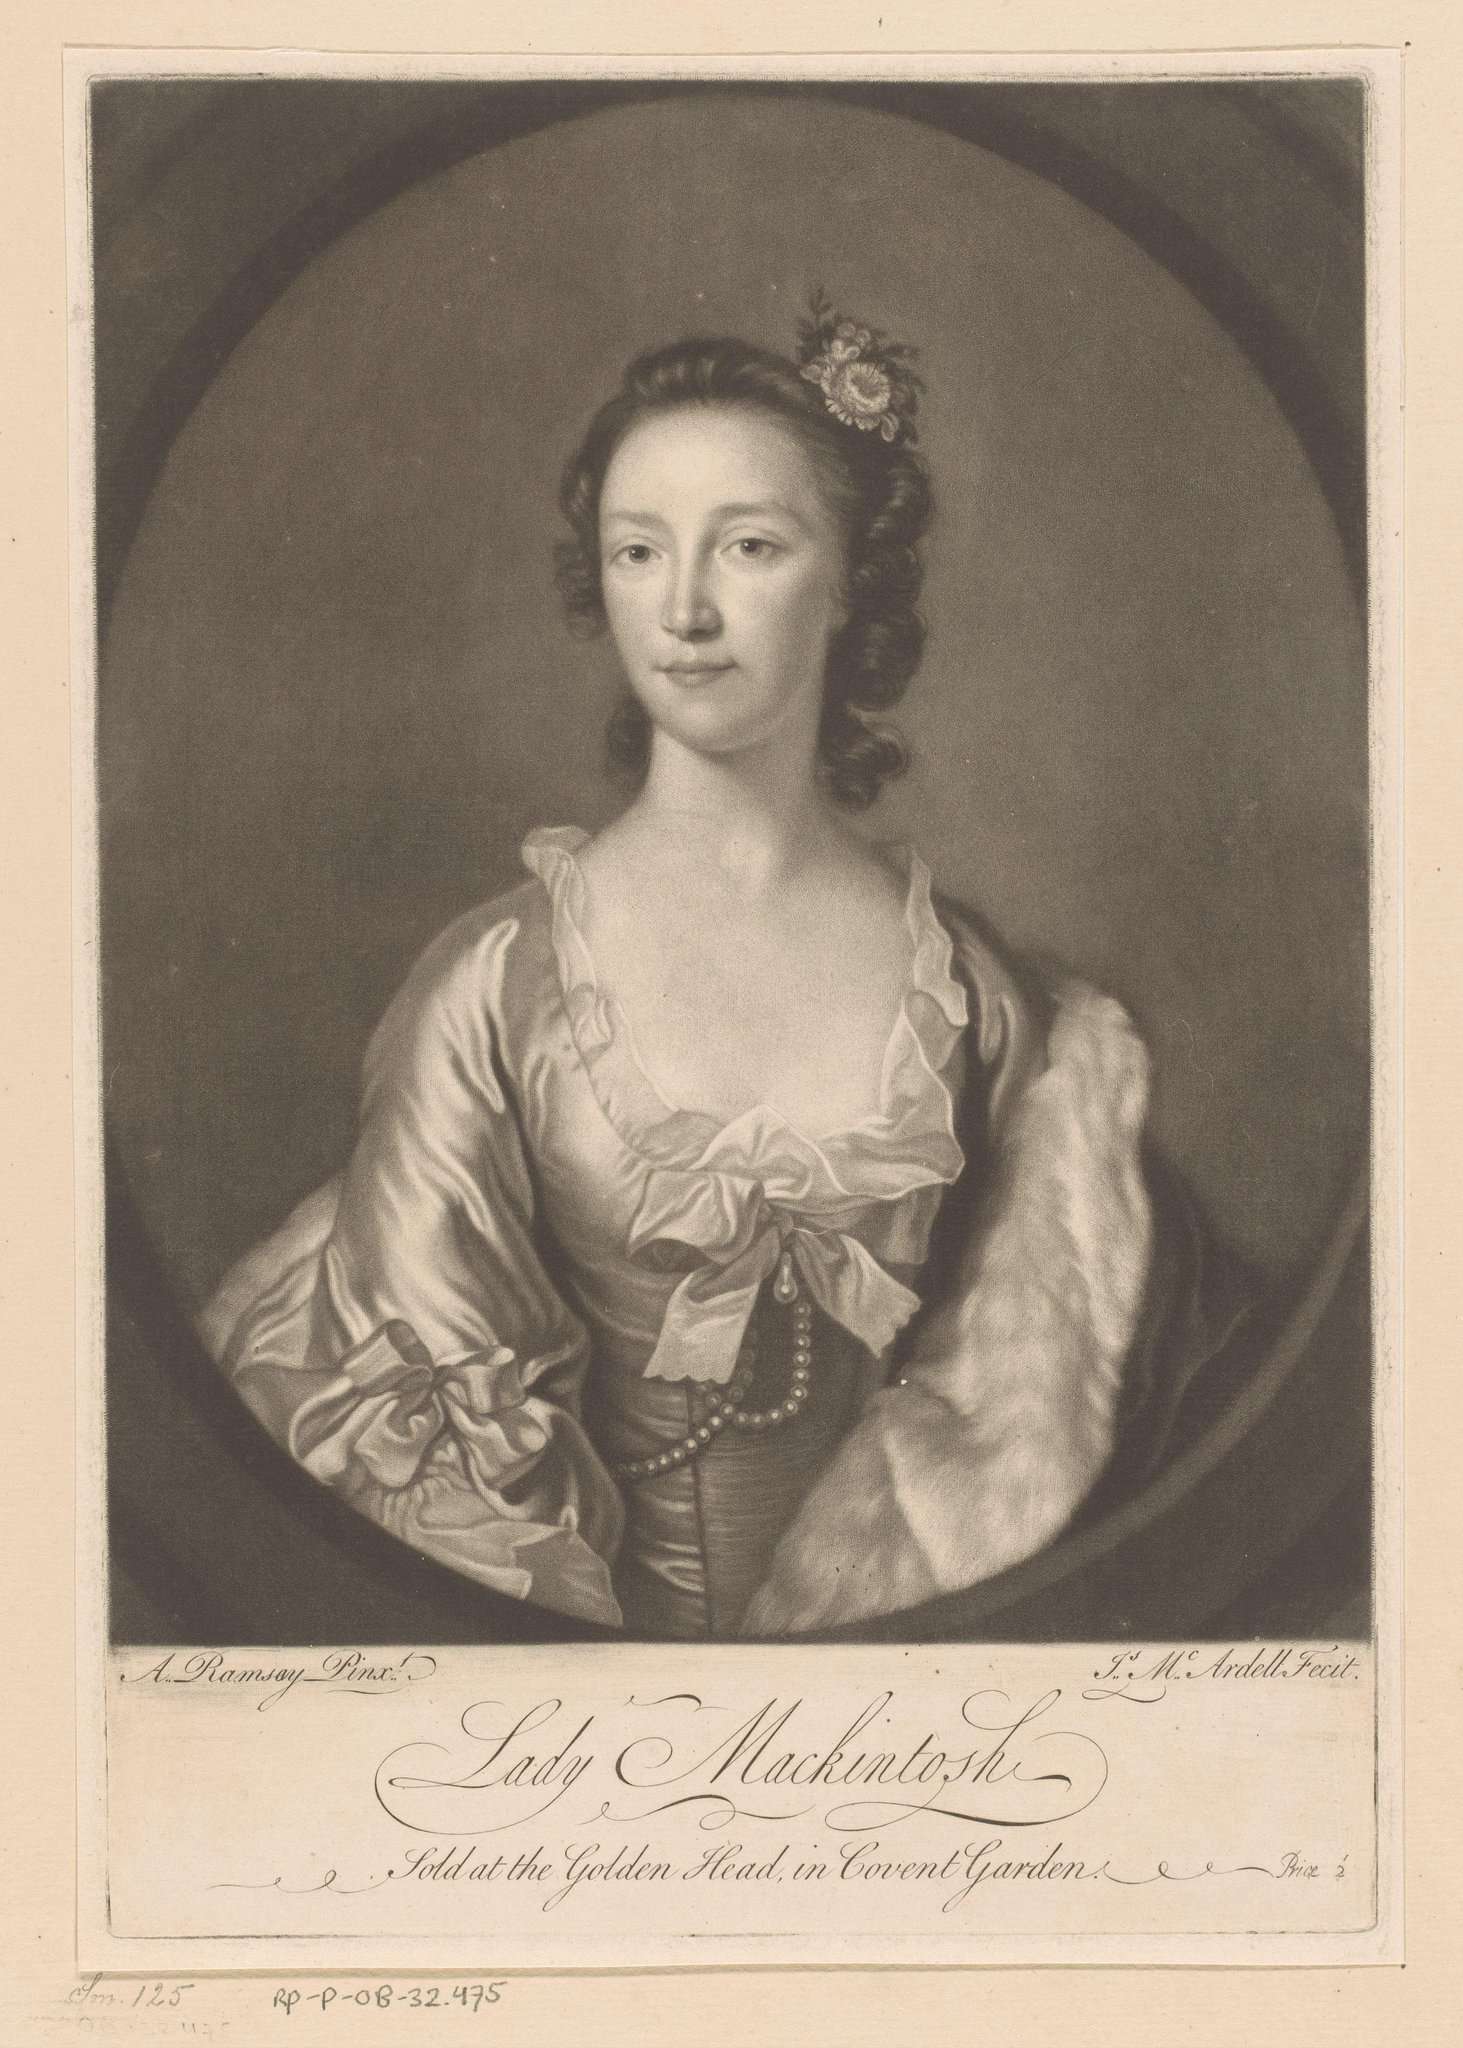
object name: print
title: Lady Mackintosh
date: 1745-1765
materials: paper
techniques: mezzotint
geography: london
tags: historical persons - bb - woman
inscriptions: collector's mark: Lugt 240